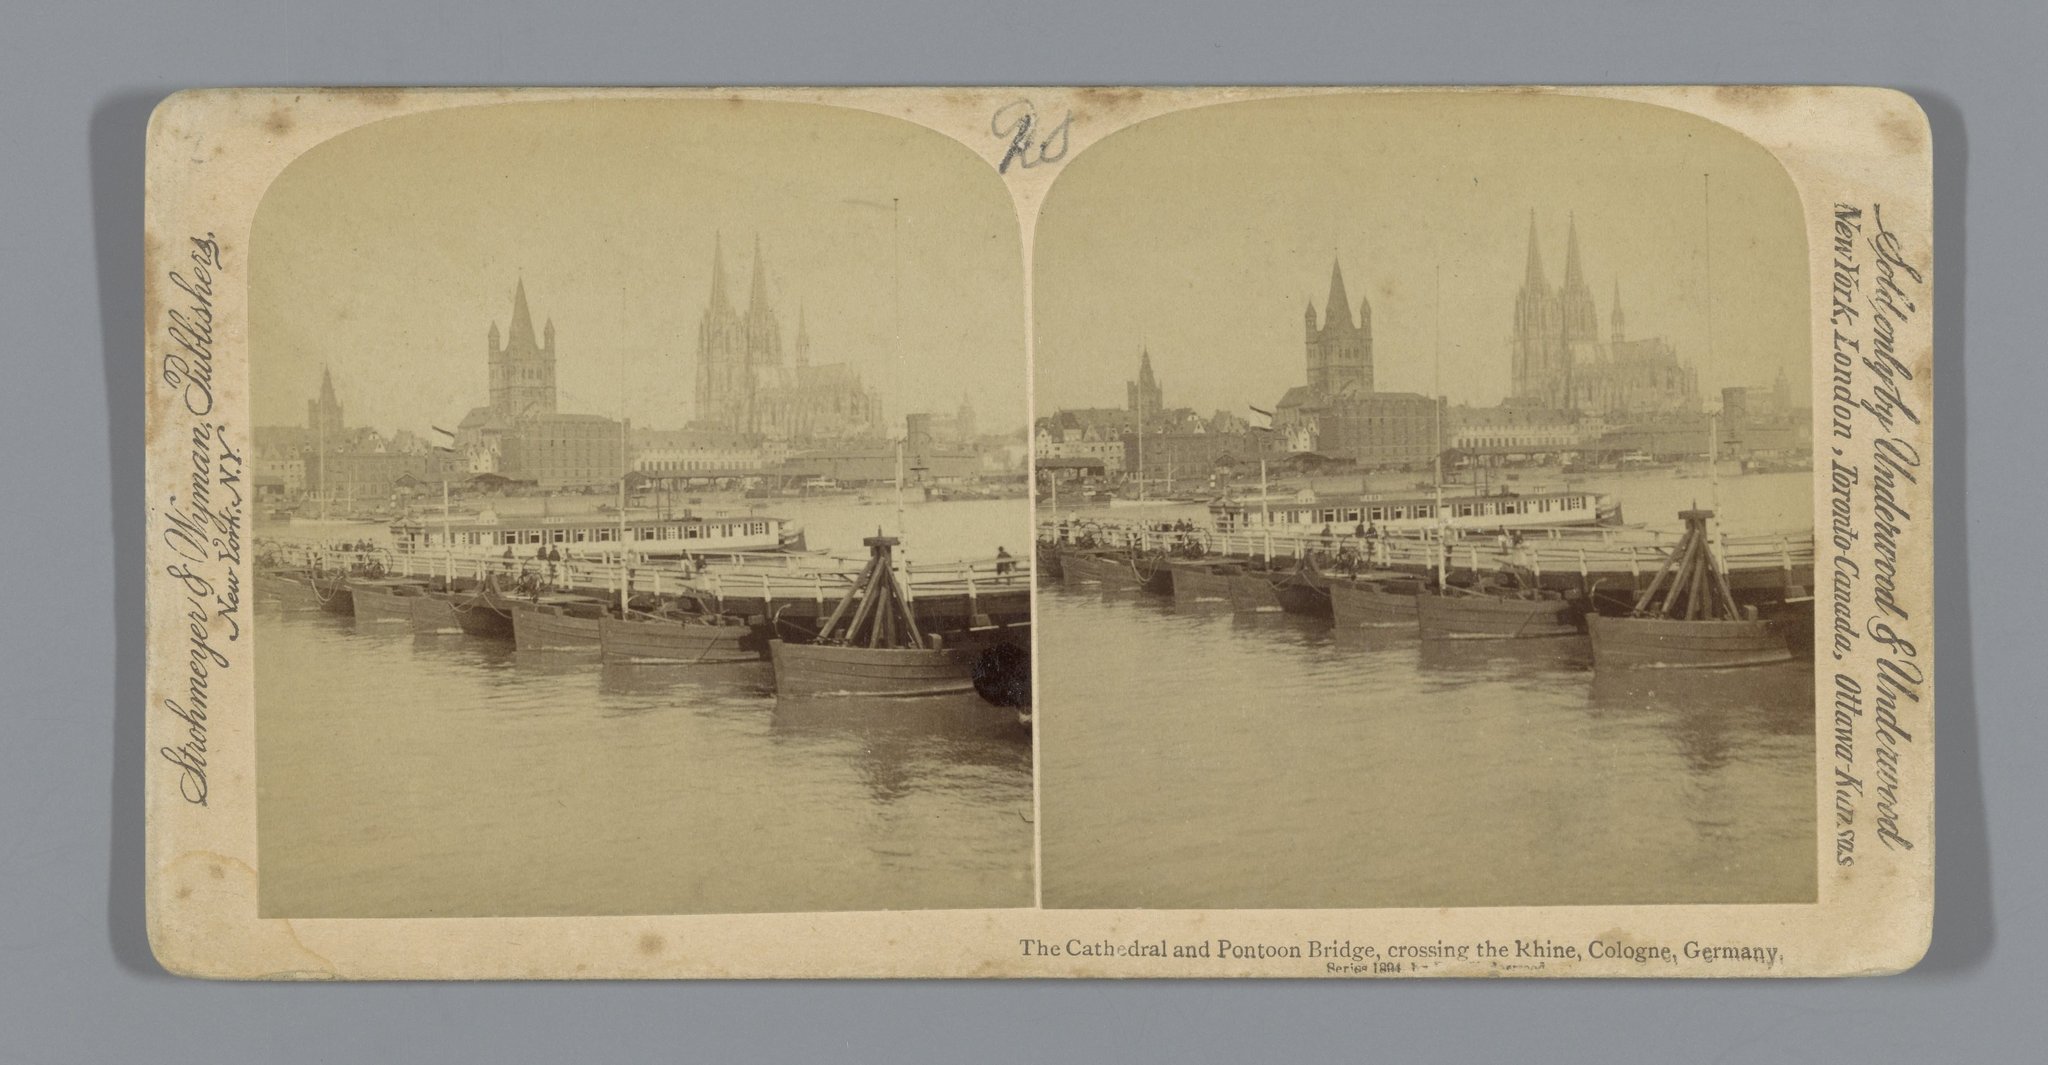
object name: stereograph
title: The Cathedral and Pontoon Bridge, crossing the Rhine, Cologne, Germany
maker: bert elias underwood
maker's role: fotograaf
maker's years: 1862-1943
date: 1894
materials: cardboard, photographic support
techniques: albumen print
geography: cologne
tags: church (exterior), pontoon bridge, cologne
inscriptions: inscription: ‘Sold only by Underwood & Underwood New York, London, Toronto, Canada, Ottawa-Kansas’